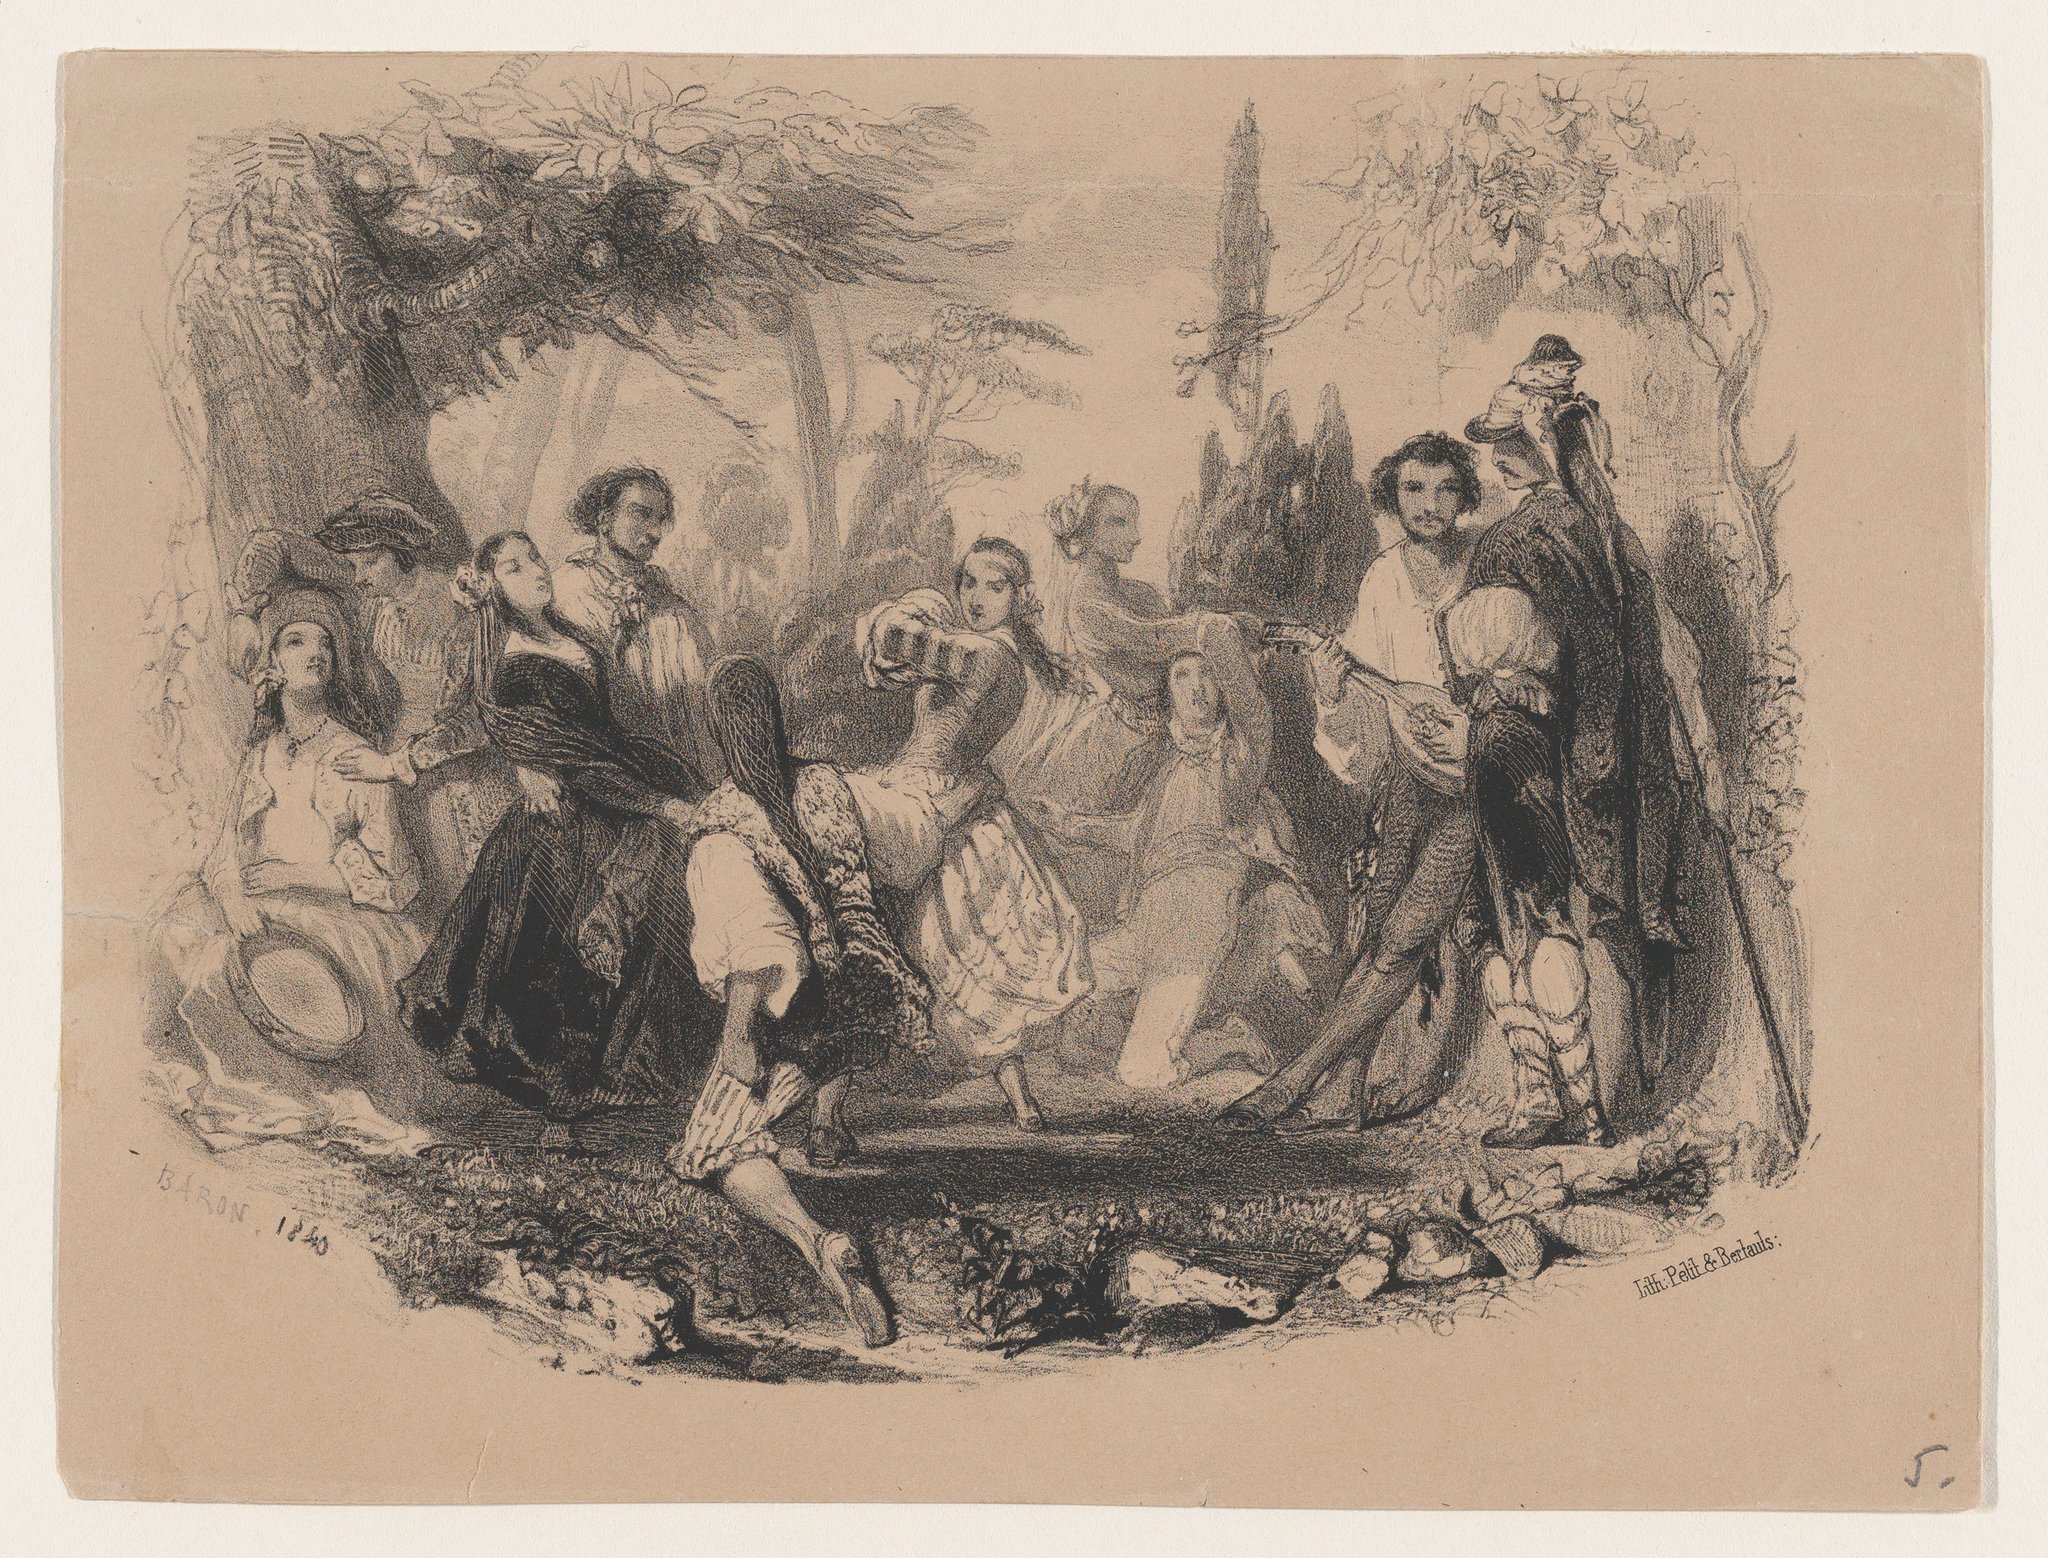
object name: print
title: Venitian Songs, Act V of Cosima; (Verso) Title page for 'Album Musical'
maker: henri-charles-antoine baron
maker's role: artist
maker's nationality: french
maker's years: 1816-1885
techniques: lithograph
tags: musical instruments,men,women